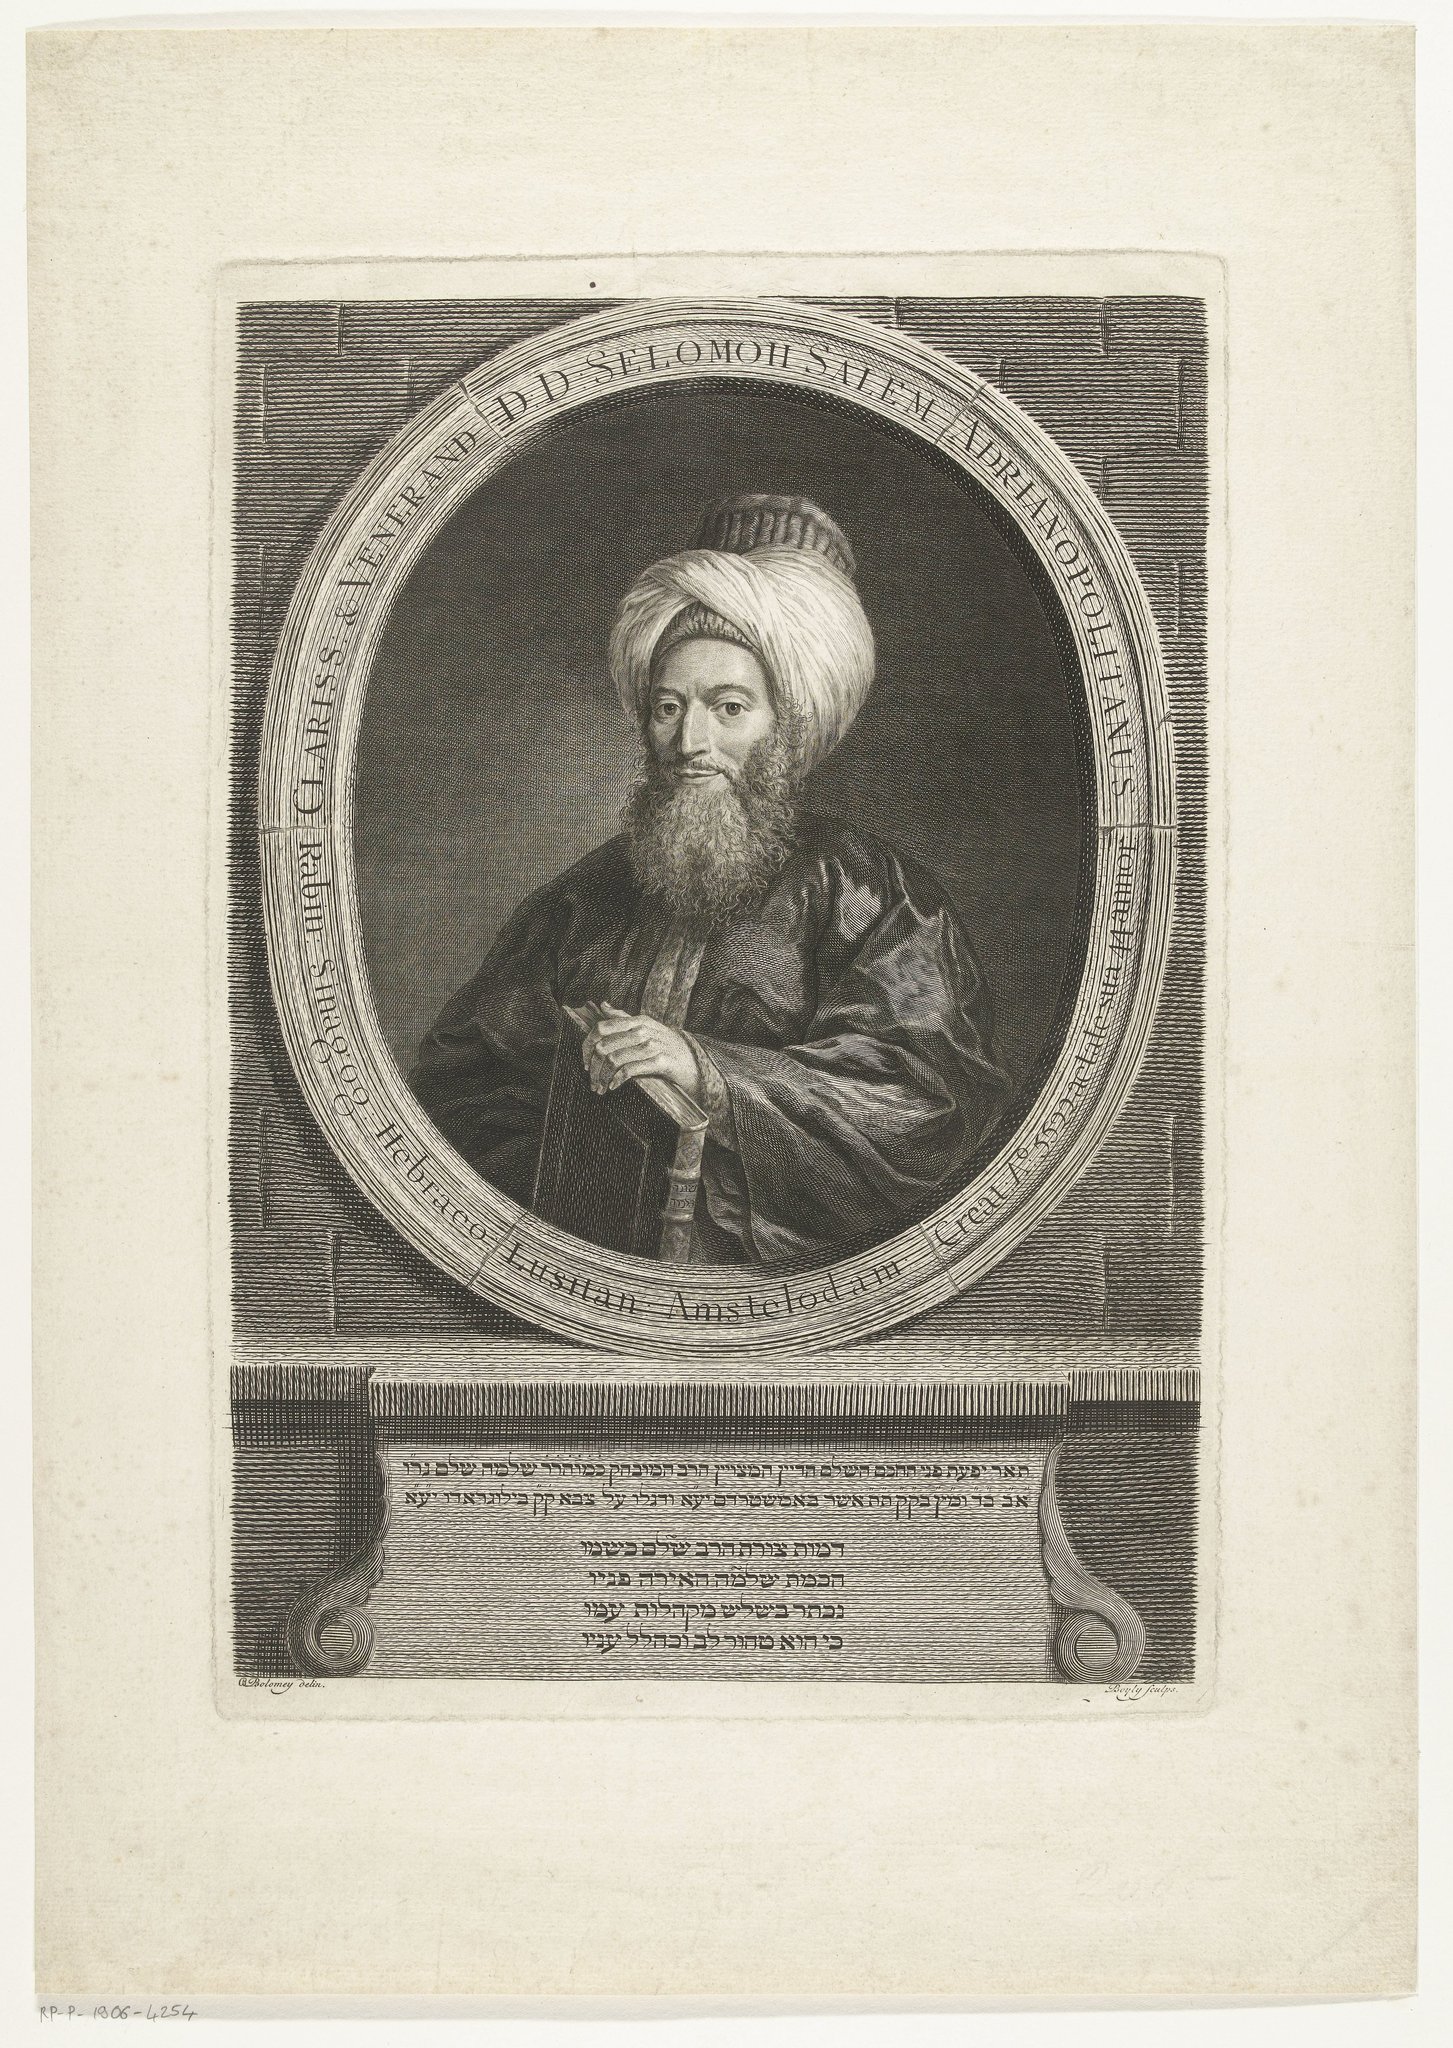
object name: print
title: Portret van Selomoh Salem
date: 1753-1813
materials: paper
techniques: engraving, etching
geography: netherlands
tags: chief rabbi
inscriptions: collector's mark: Lugt 2228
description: Borstbeeld van Salomon Salem, de opperrabbijn van de Portugees-Israëlitische gemeente te Amsterdam, in ovaal met randschrift. Op de sokkel van het portret een tekst in Hebreeuws.